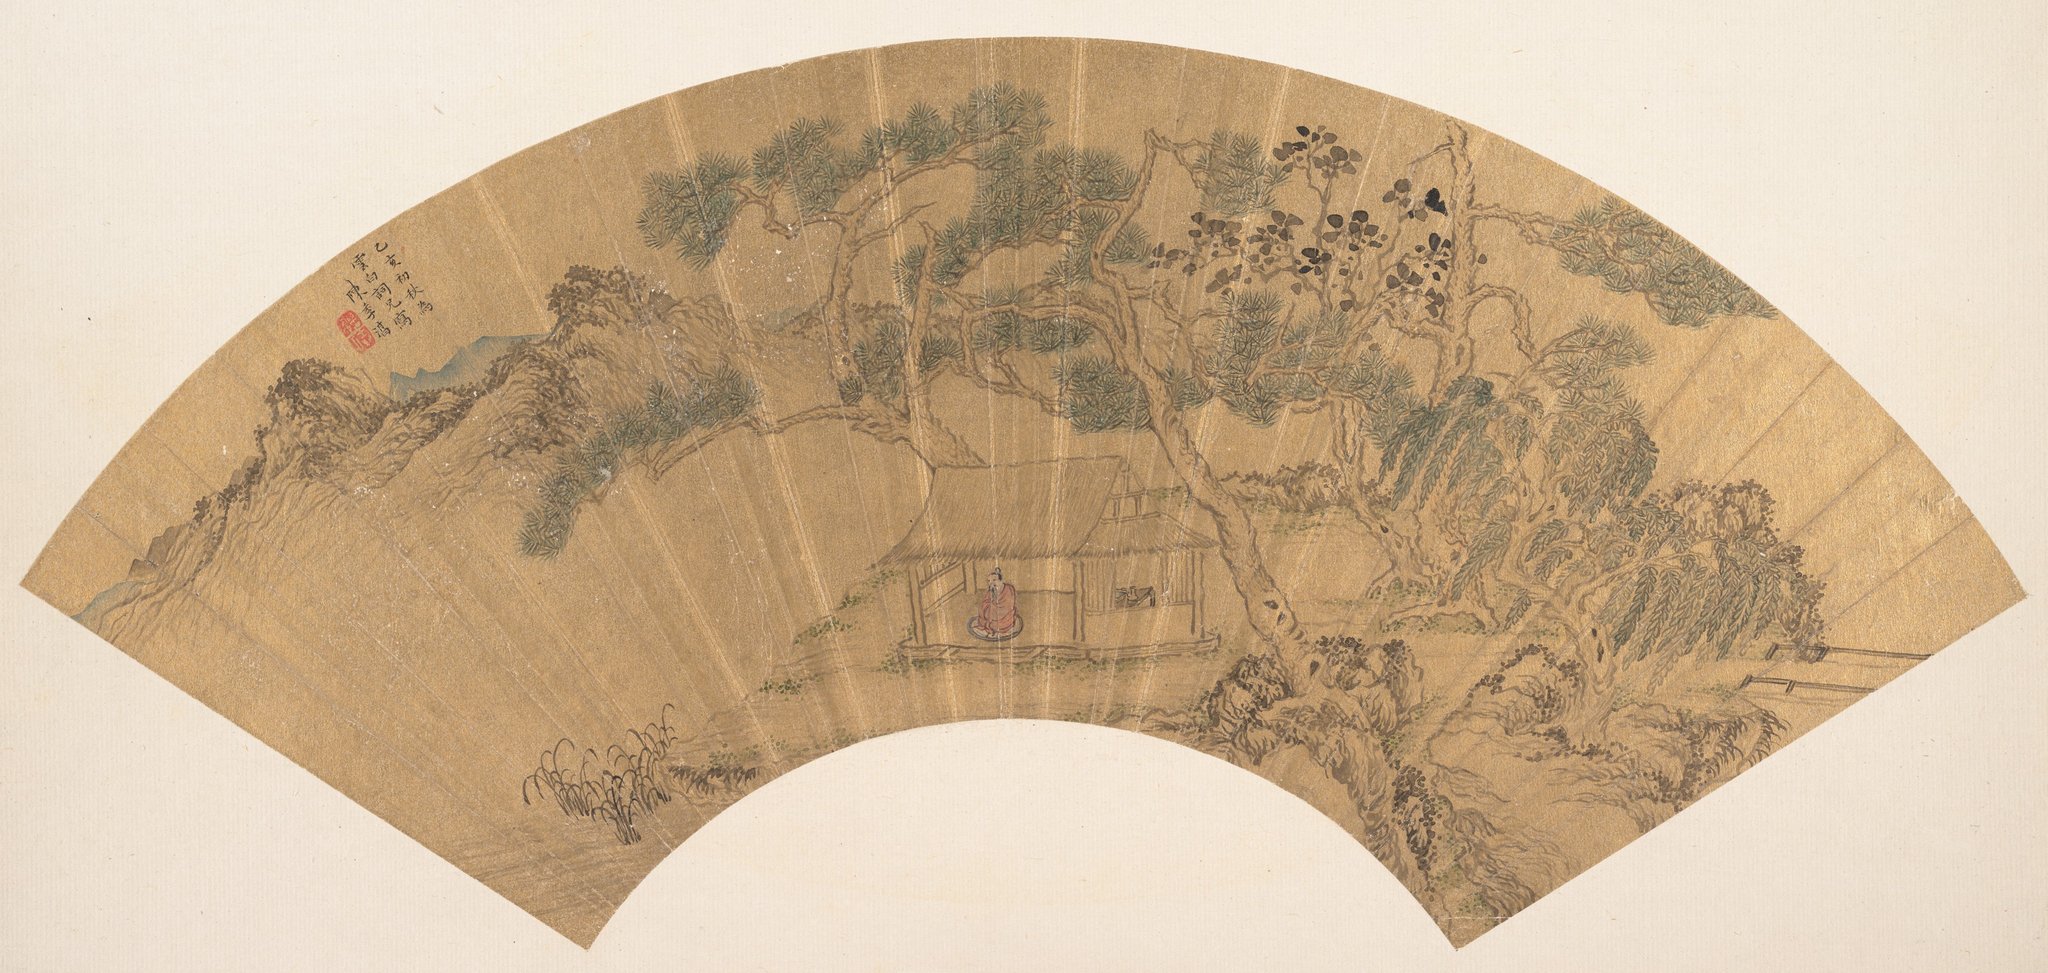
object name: folding fan mounted a an album leaf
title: Landscape with figure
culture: chinese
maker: chen jichun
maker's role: artist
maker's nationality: chinese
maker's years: 1633-1667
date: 1635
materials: gold, ink, paper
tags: landscapes,trees,pavilions